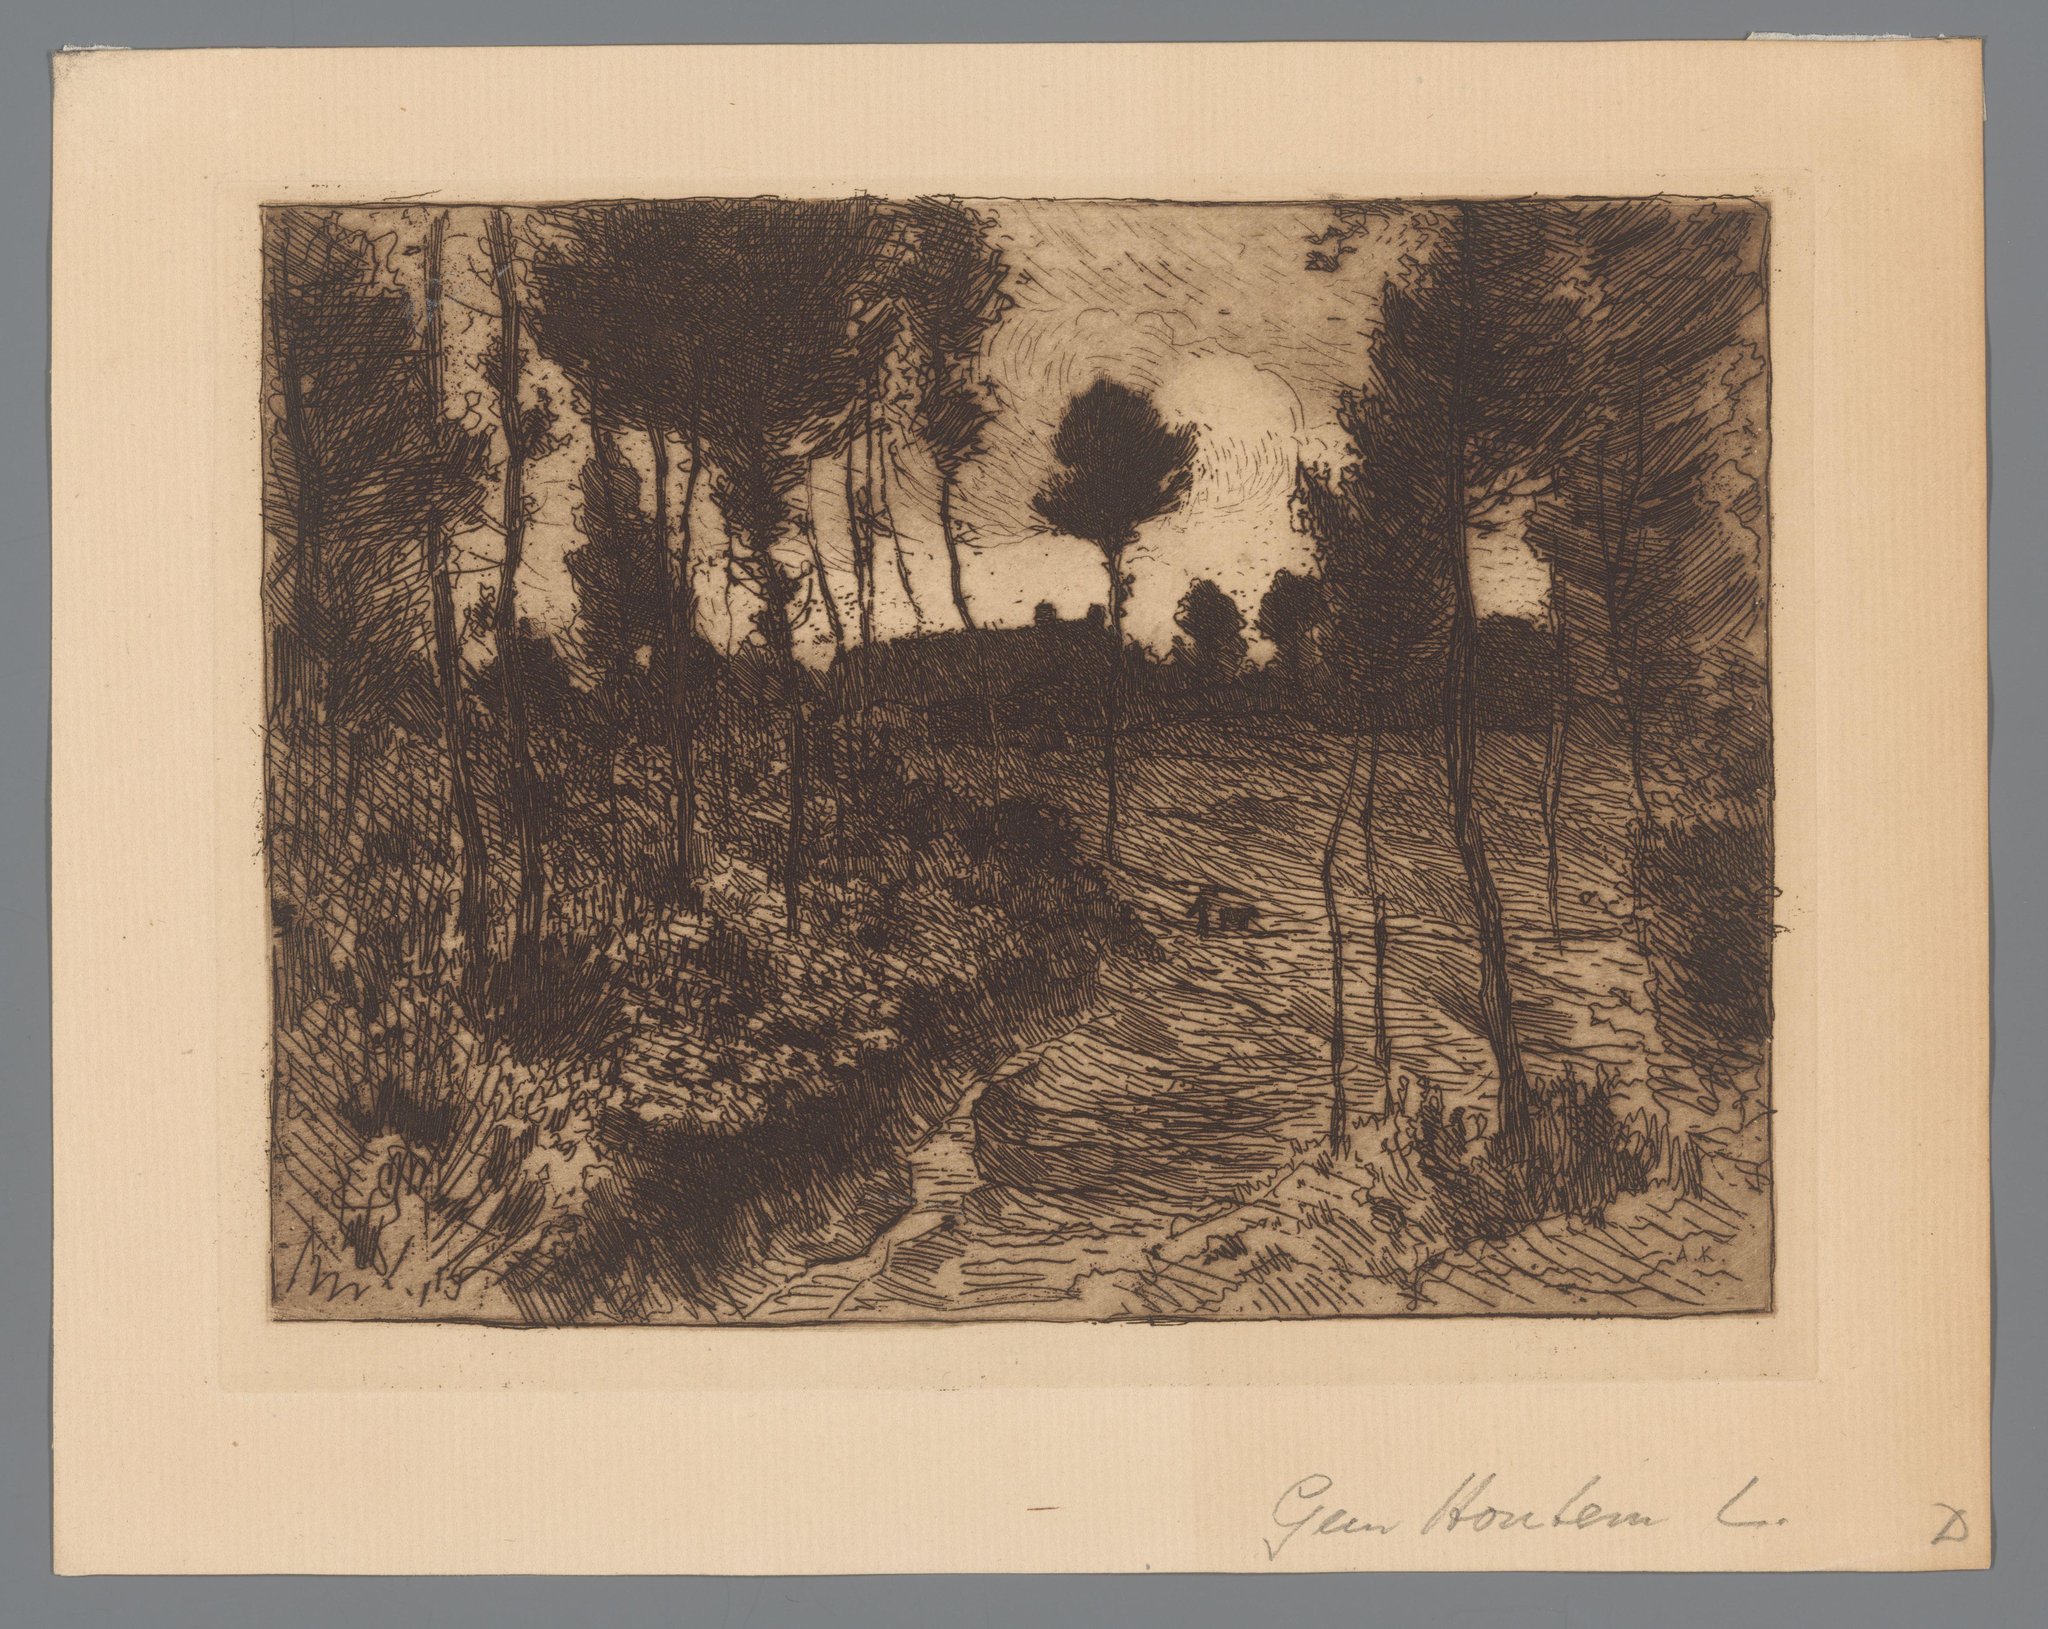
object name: print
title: Bosweg bij avond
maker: anton l. koster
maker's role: draughtsman, painter, print maker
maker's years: 1859-1937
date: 1869-1924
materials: paper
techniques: etching, intaglio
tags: evening, forest path or lane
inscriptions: collector's mark: Lugt 2228